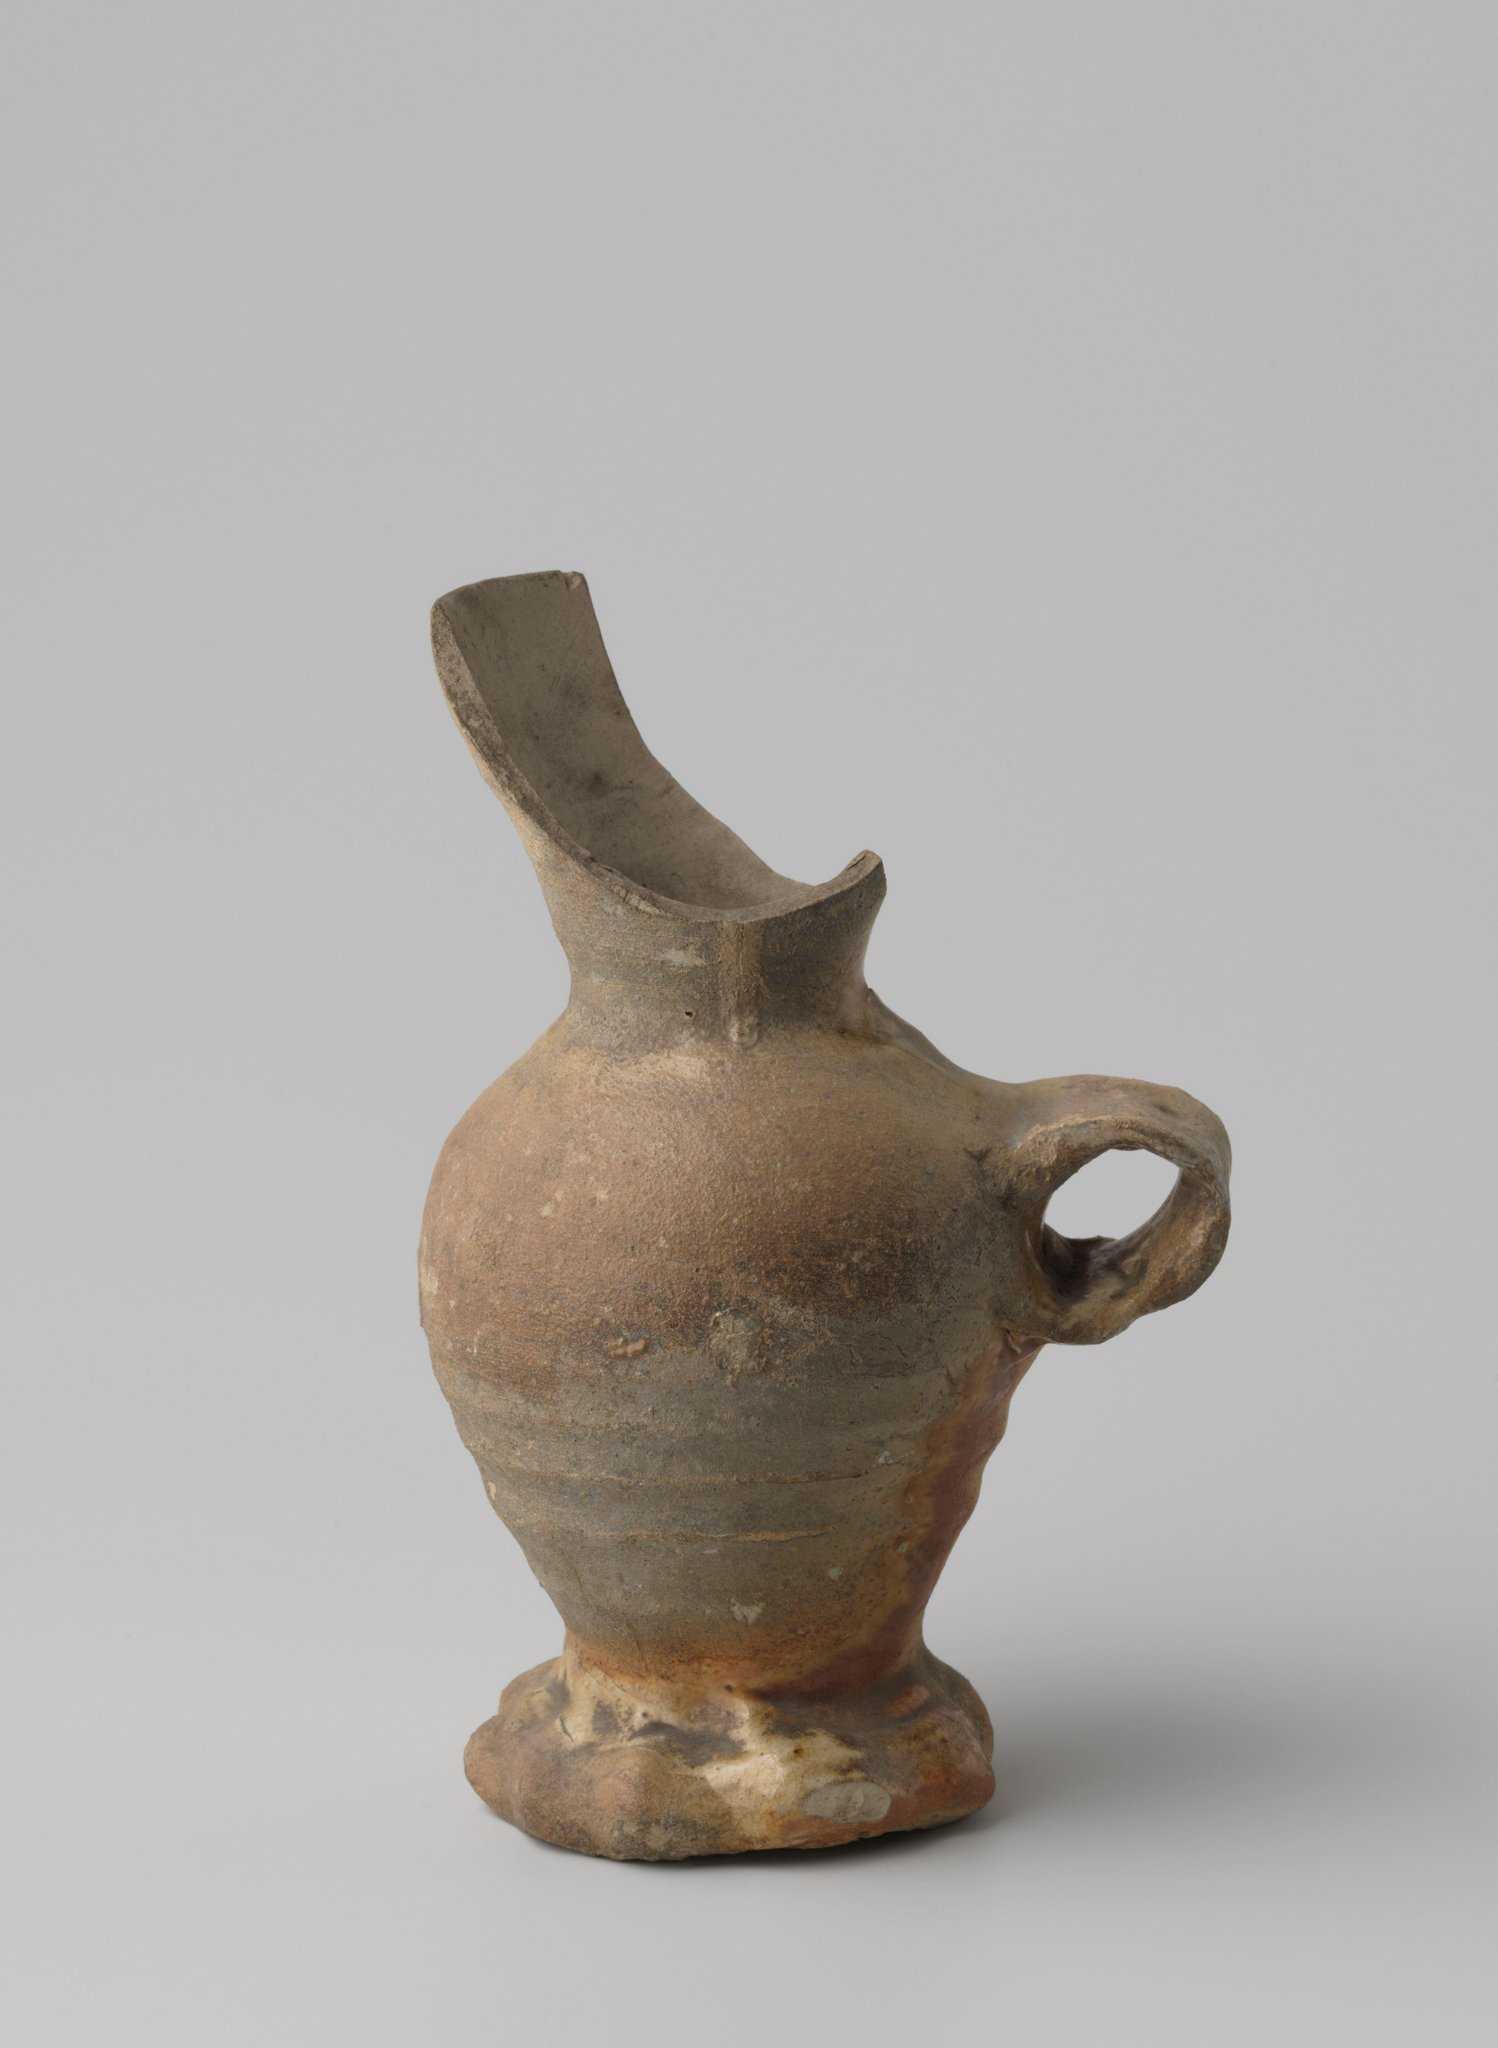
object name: fragment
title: Jug 'trichterhalskrug' with rilling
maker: Anonymous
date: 1550-1699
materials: glaze, stoneware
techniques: firing, forming, turning, vitrification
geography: germany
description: Fragment van een kruik (trechterhalskruik) van steengoed op golvende voet met een eivormige buik en trechtervormige nek. Deel van de nek ontbreekt. Het C-vormige oor is bevestigd aan de schouder. De kan is versierd met draairingen.